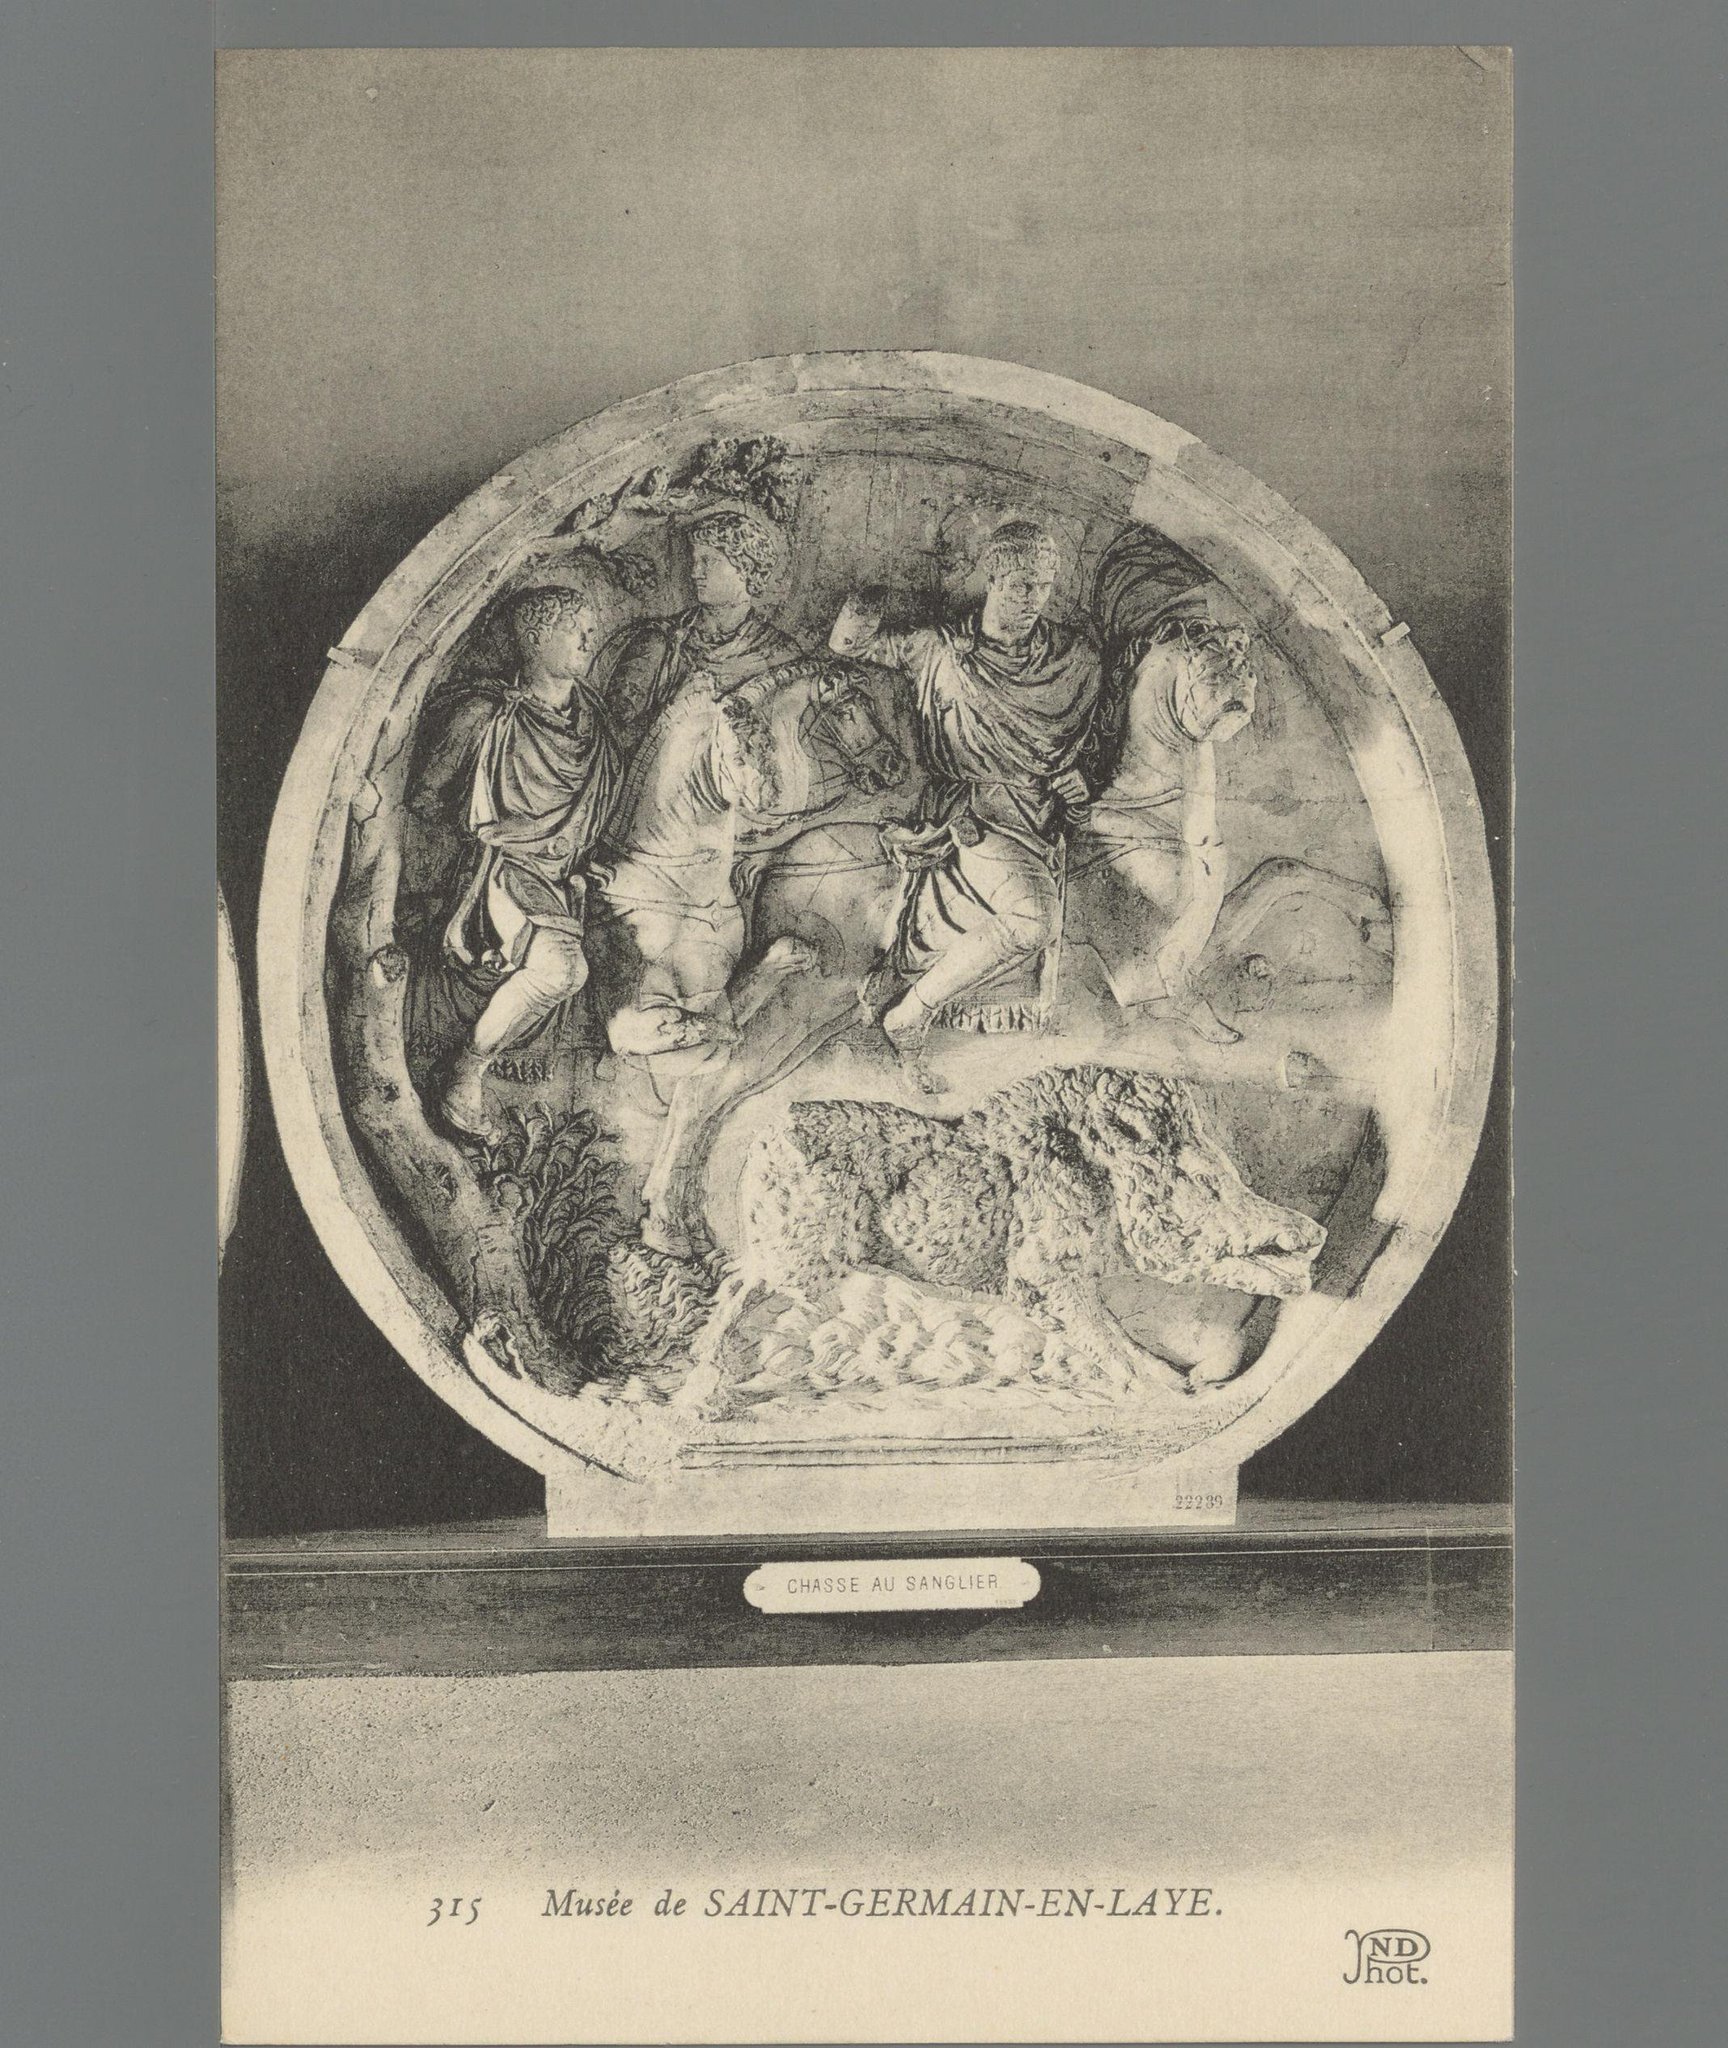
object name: ansichtkaart, prentbriefkaart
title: Musée de Saint-Germain-en-Laye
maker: Anonymous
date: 1903-1918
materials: cardboard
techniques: photograph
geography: paris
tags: permanent exhibition, museum, sculpture